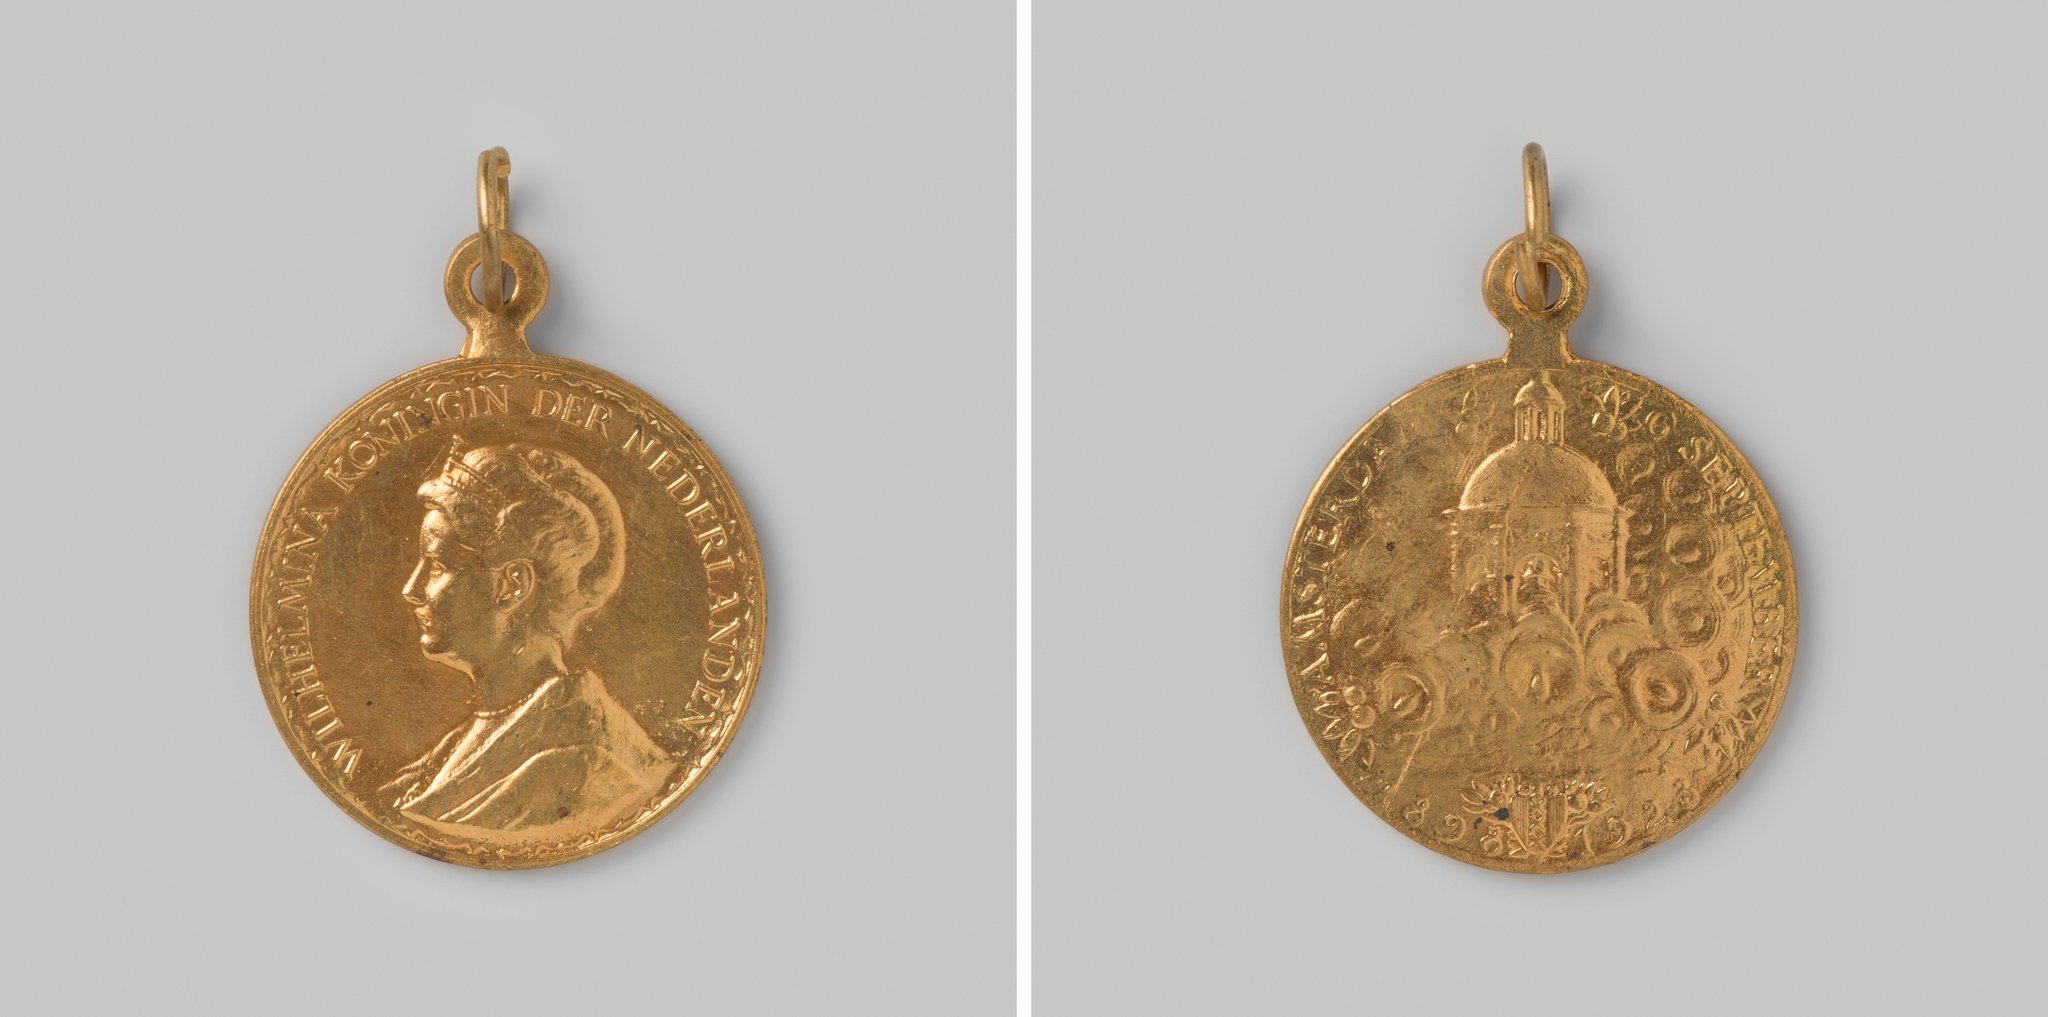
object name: history medal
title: Vijfentwintigjarig regeringsjubileum van Koningin Wilhelmina 1923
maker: johannes cornelis wienecke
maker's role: medailleur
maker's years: 1872-1945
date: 1923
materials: brass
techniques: striking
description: Messing penning met ring en draagoog, op de voorzijde het borstbeeld van Wilhelmina naar links met omschrift, op de keerzijde een kerkkoepel te miden van luidende klokken en oranjebloesem, met omschrift, onderaan het Amsterdamse stadswapen tussen oranjetakken en twee jaartallen.